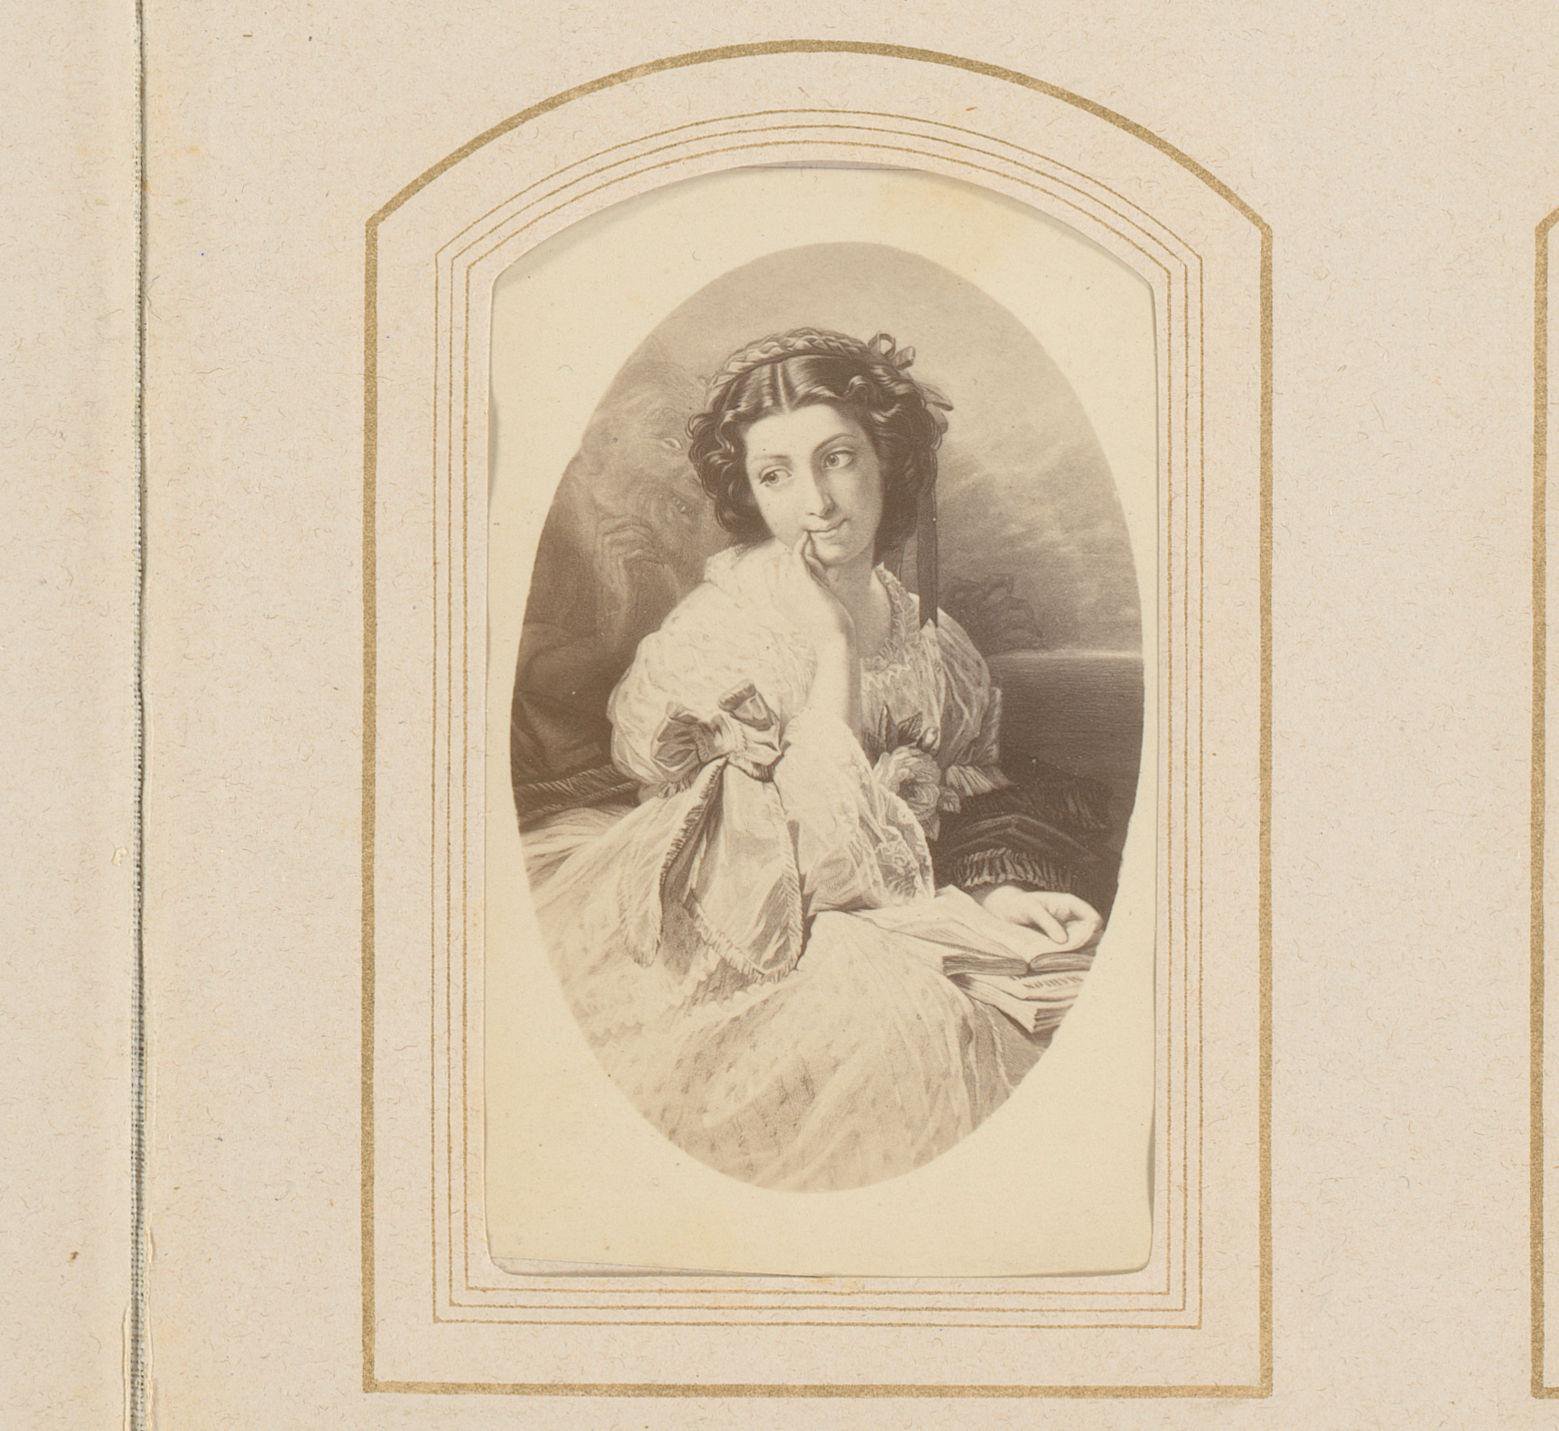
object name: album leaf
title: Fotoreproductie van Das Slechte Buch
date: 1870-1890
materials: cardboard, photographic support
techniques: albumen print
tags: adult woman, book - mm - book open, painting, drawing and the graphic arts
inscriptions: annotation: ‘Das Slechte Buch’, number